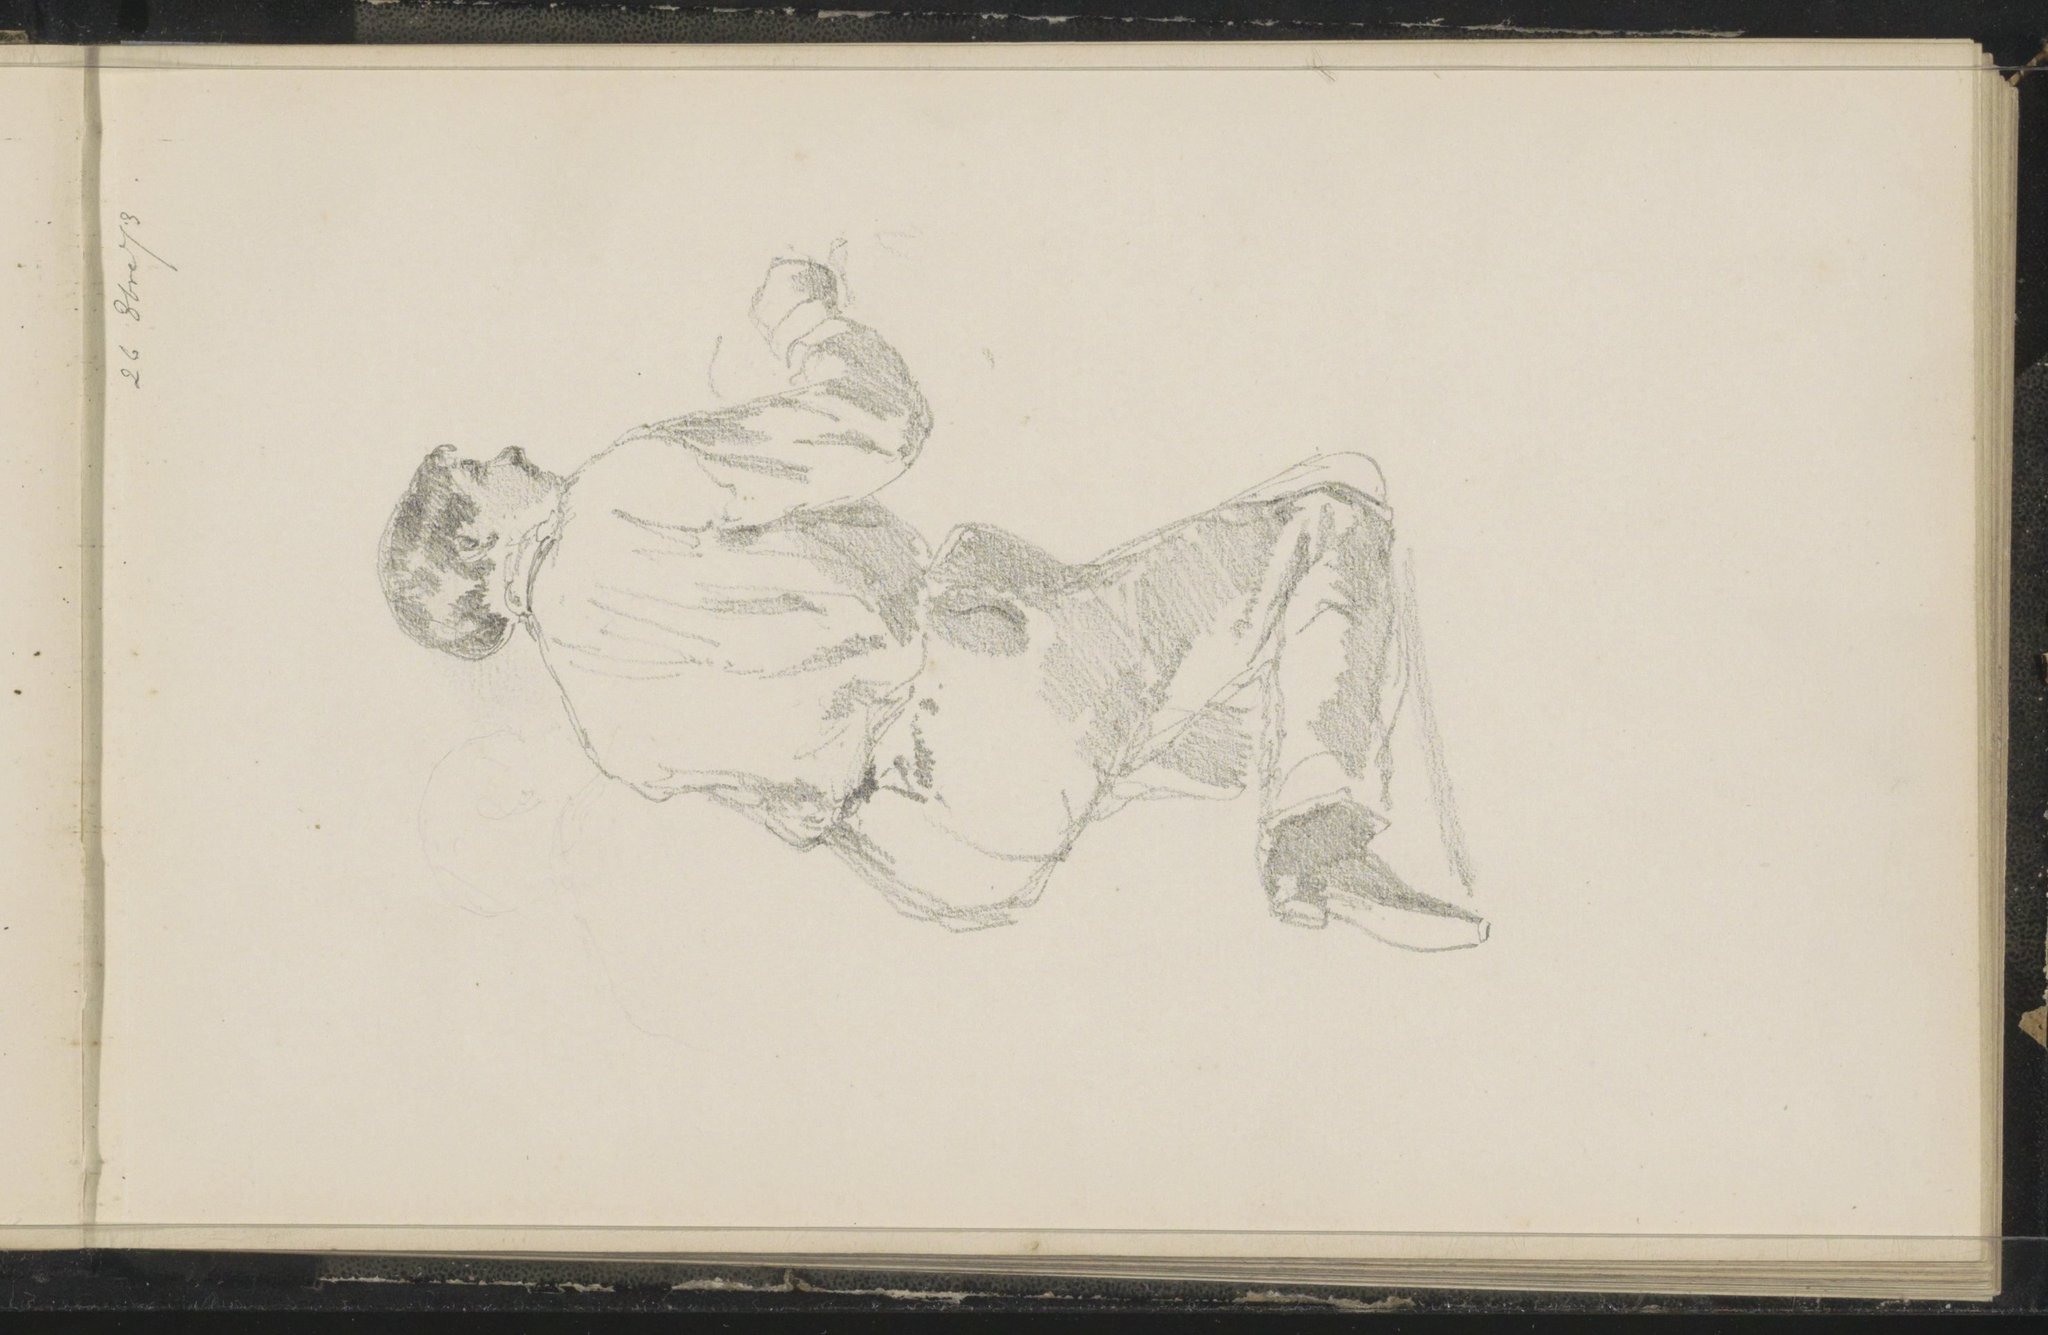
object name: sketchbook leaf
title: Knielende man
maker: cornelis springer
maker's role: draughtsman, painter, print maker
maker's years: 1817-1891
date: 1873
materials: paper, pencil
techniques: stumping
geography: netherlands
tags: kneeling figure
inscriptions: date: ‘26 [...]bre 73’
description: Een man knielt op één knie. Blad 7 uit een schetsboek met 46 bladen.